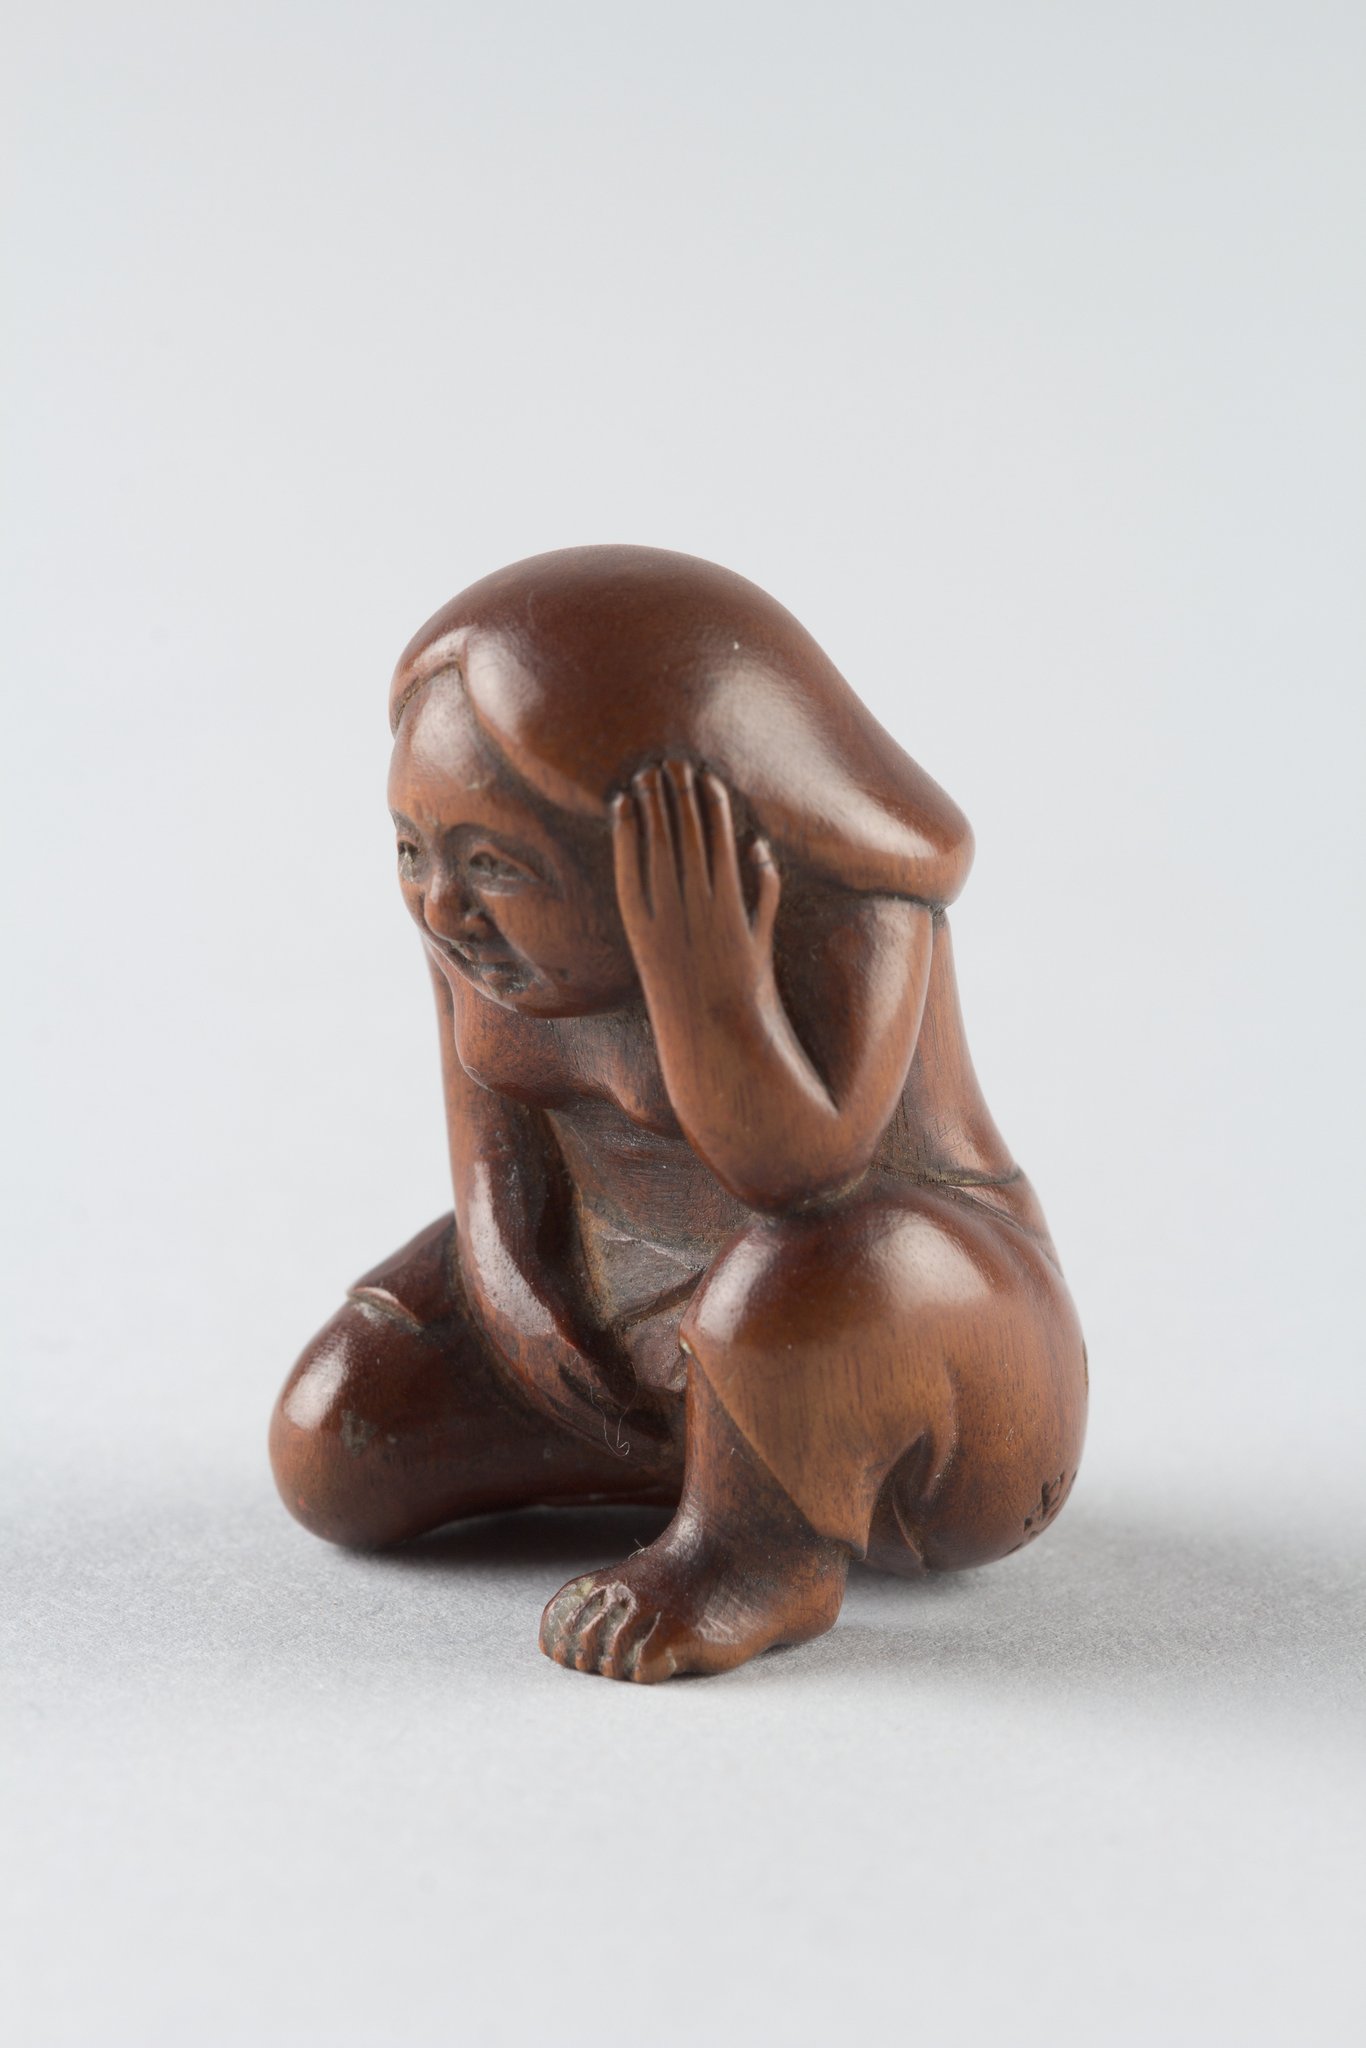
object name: netsuke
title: Netsuke of Woman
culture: japanese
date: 1701-1800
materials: wood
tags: women